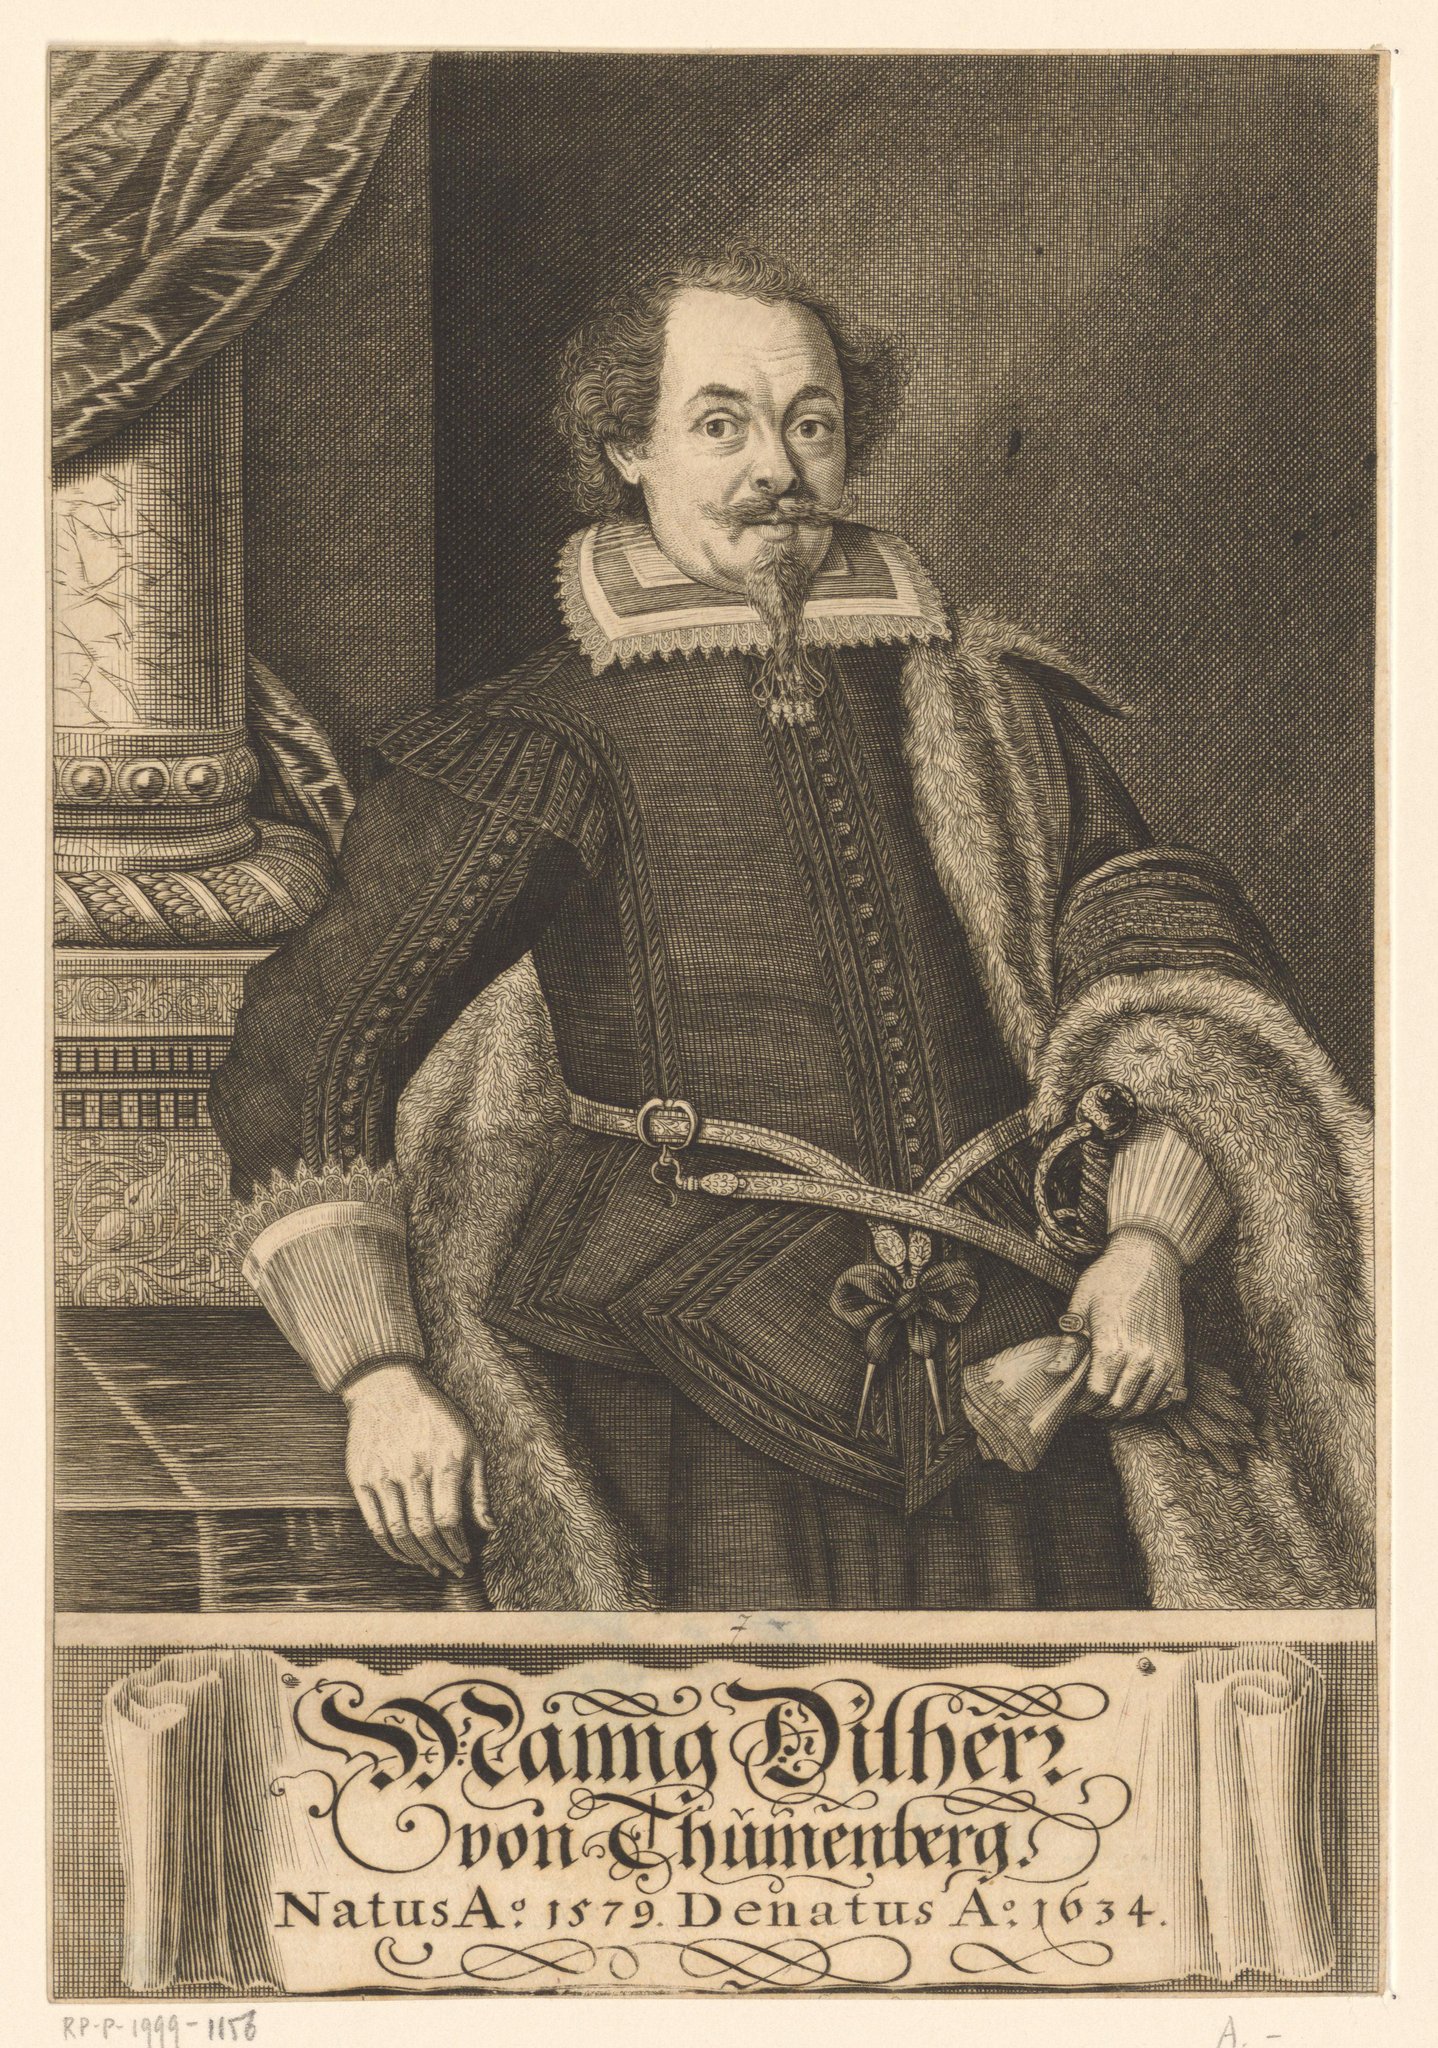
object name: print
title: Portret van Magnus Dilherr von Thummenberg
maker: Anonymous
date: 1634-1650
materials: paper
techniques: engraving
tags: historical persons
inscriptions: collector's mark: Lugt 2228, collector's mark: Lugt 2760